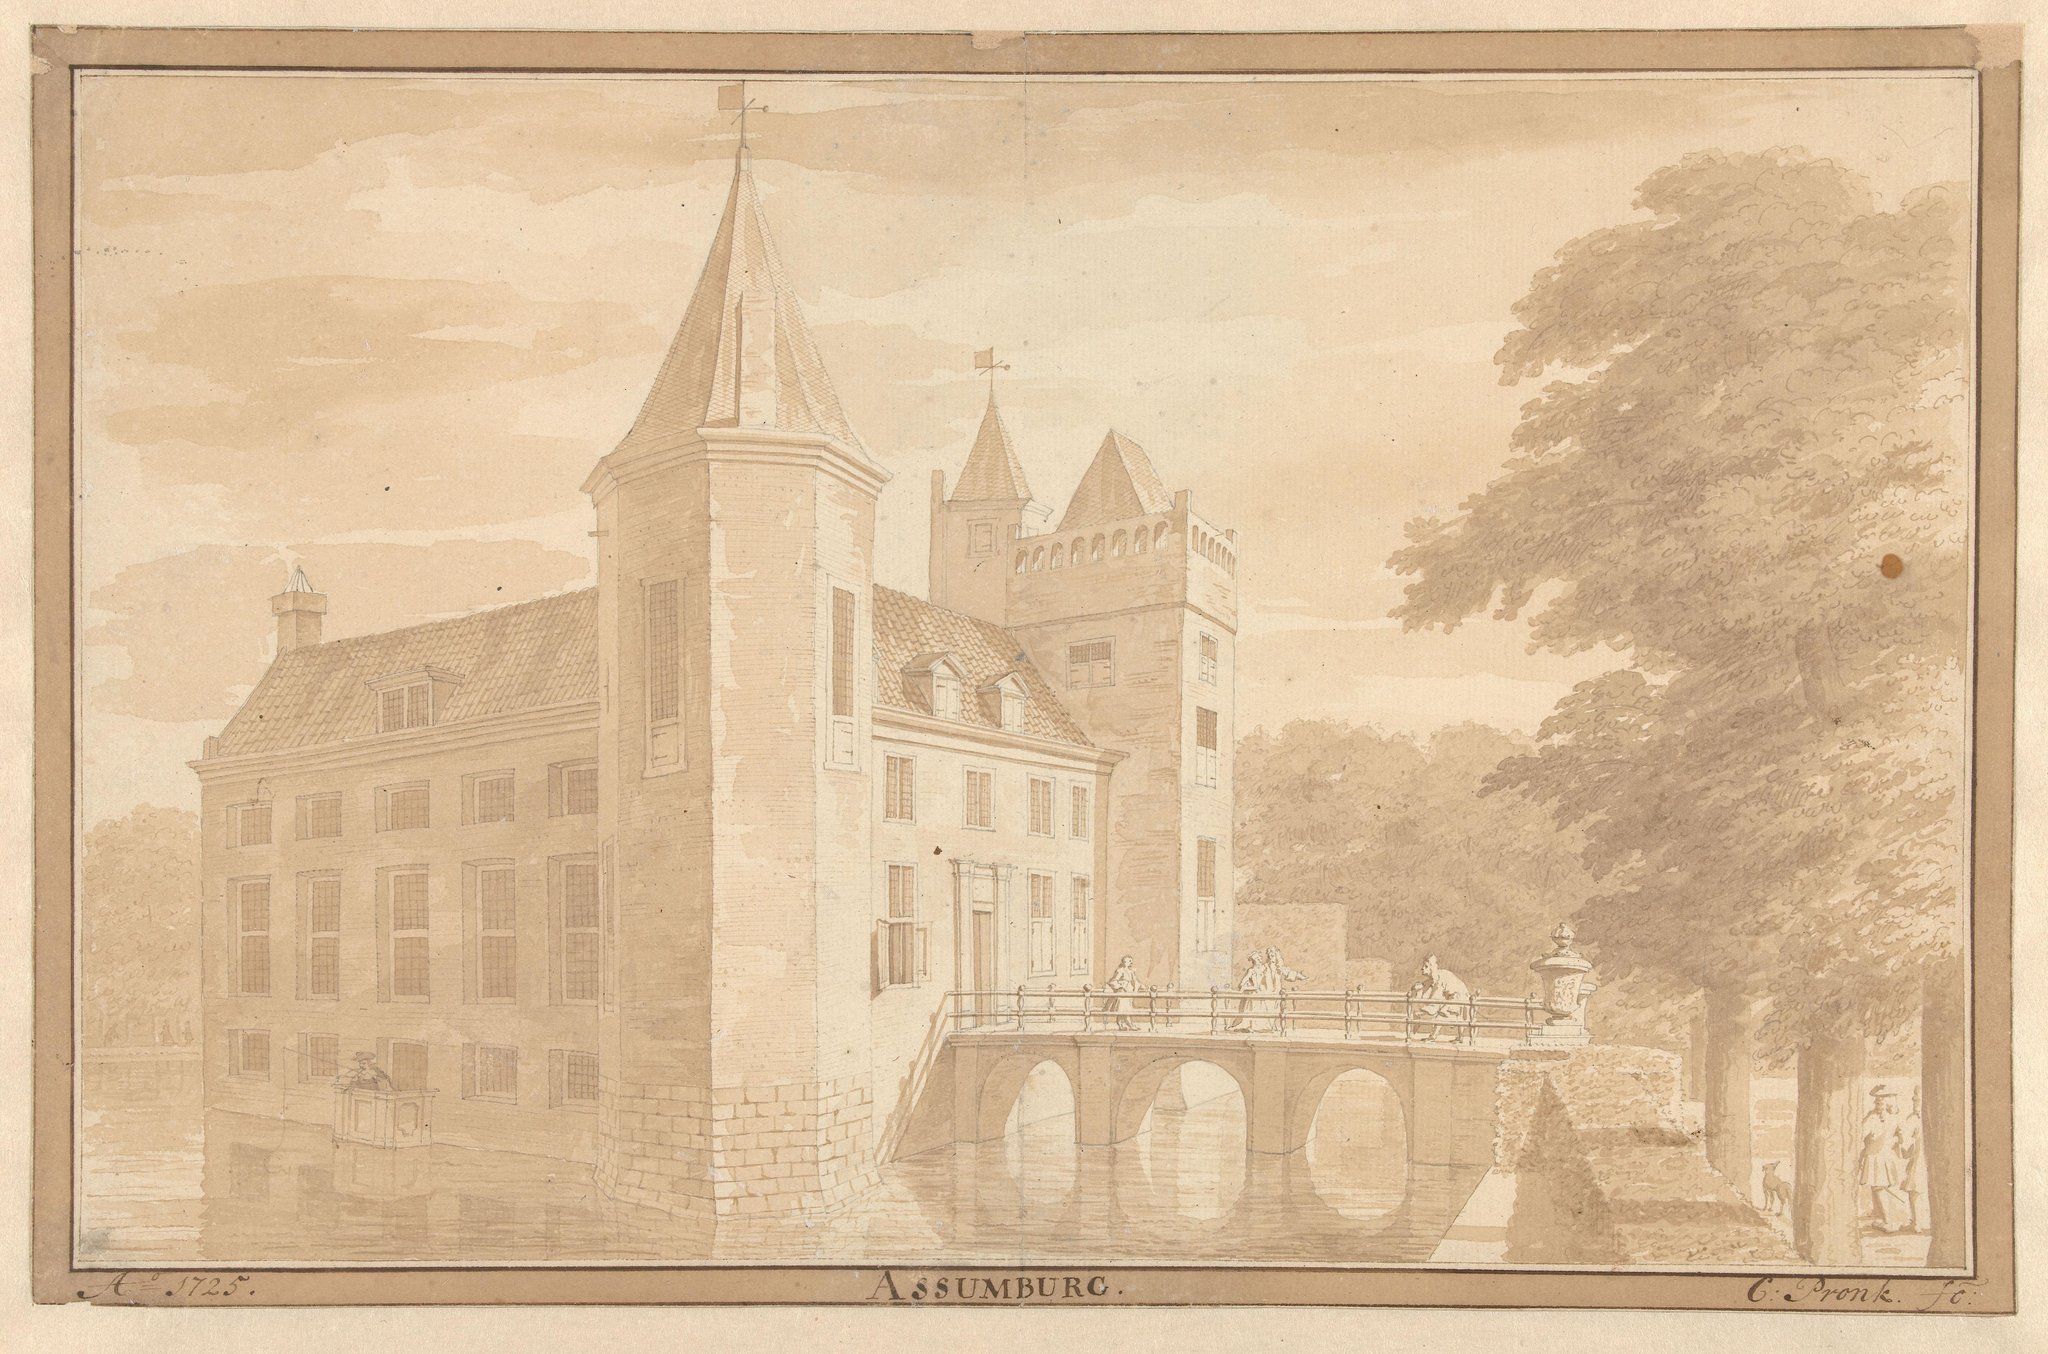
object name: drawing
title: Assumburg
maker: cornelis pronk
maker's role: draughtsman, painter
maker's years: 1691-1759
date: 1725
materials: ink, paper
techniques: brush, pen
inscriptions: date